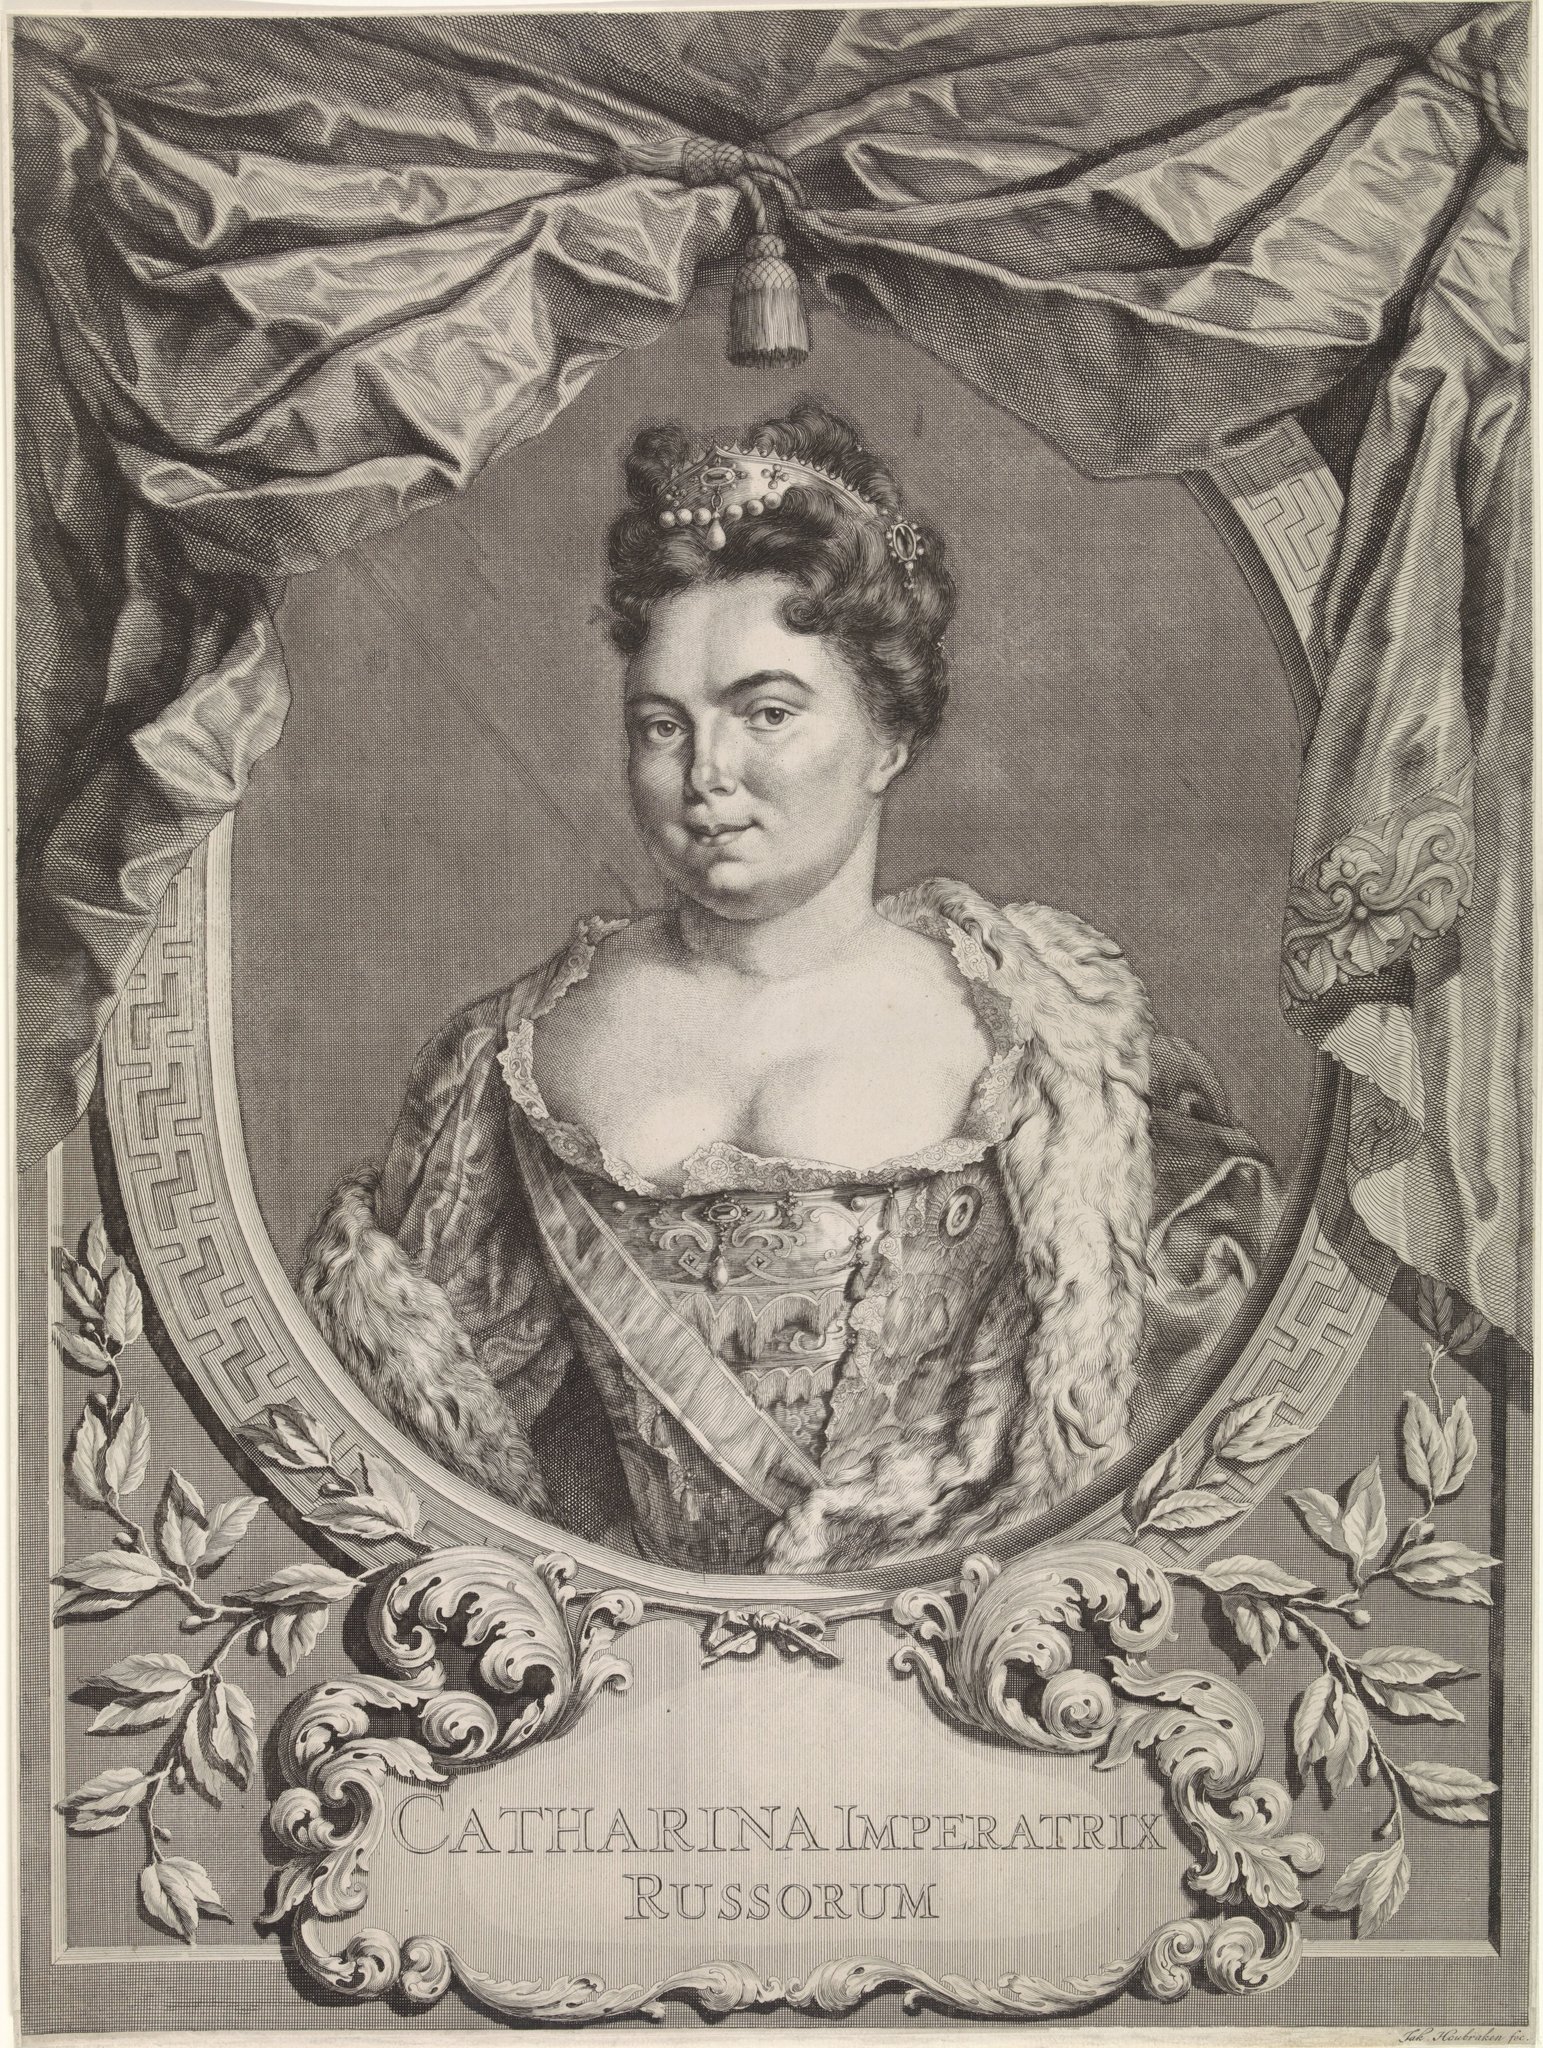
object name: print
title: Portret van Catharina I, keizerin van Rusland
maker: jacob houbraken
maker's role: draughtsman, print maker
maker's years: 1698-1780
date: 1725-1780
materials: paper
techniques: engraving, etching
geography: amsterdam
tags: keizerin, catharina i (keizerin van rusland)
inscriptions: collector's mark: Lugt 2228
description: Pendant van het portret van Peter I de Grote, tsaar van Rusland (RP-P-OB-67.704).